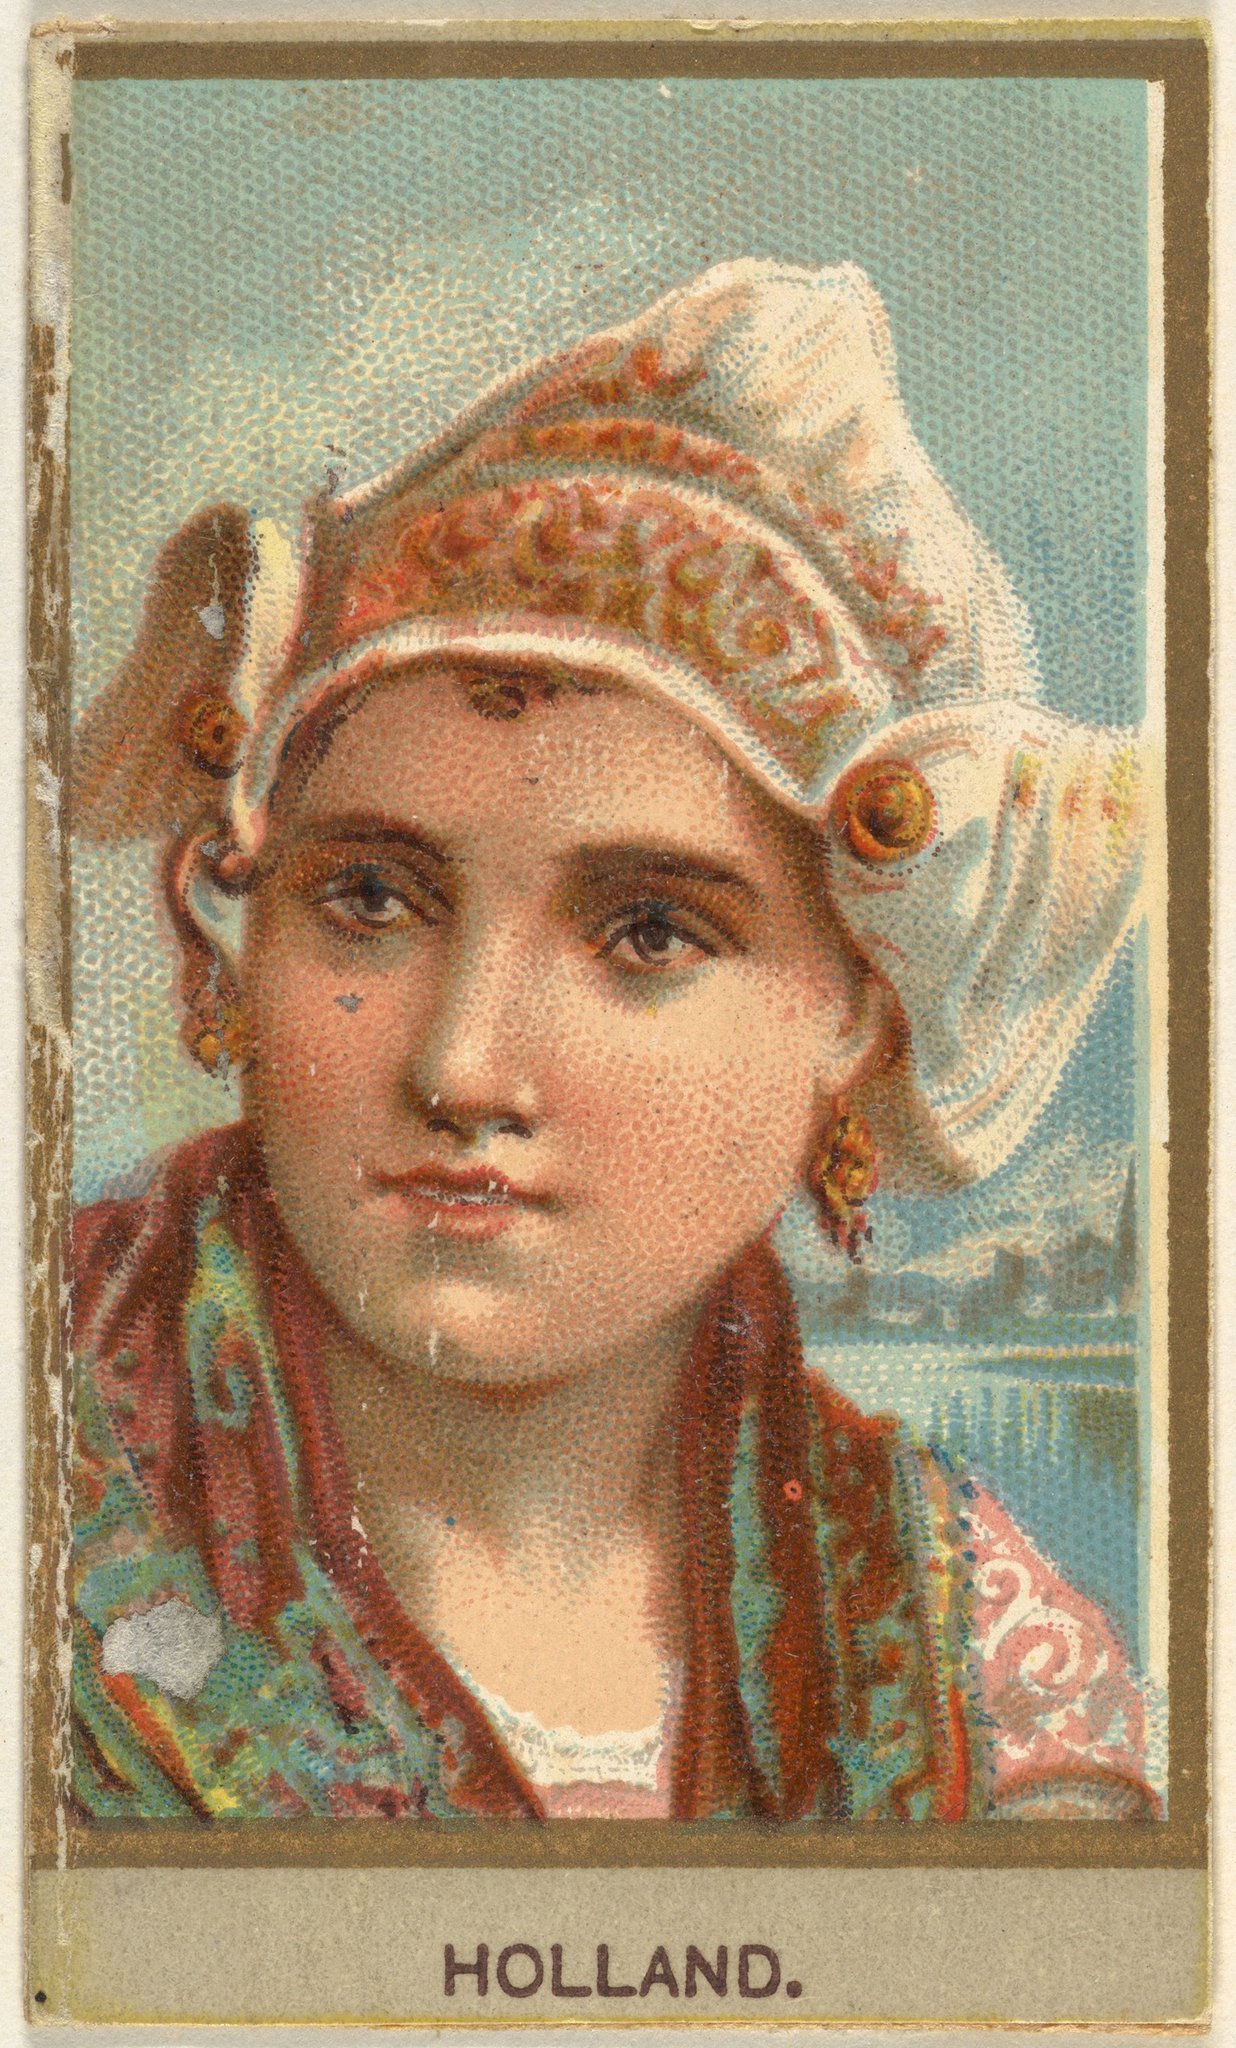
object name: print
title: Holland, from the Races of Mankind series (T181) issued by Abdul Cigarettes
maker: abdul cigarettes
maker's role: publisher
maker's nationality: american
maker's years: 1881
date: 1881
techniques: color lithograph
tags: women